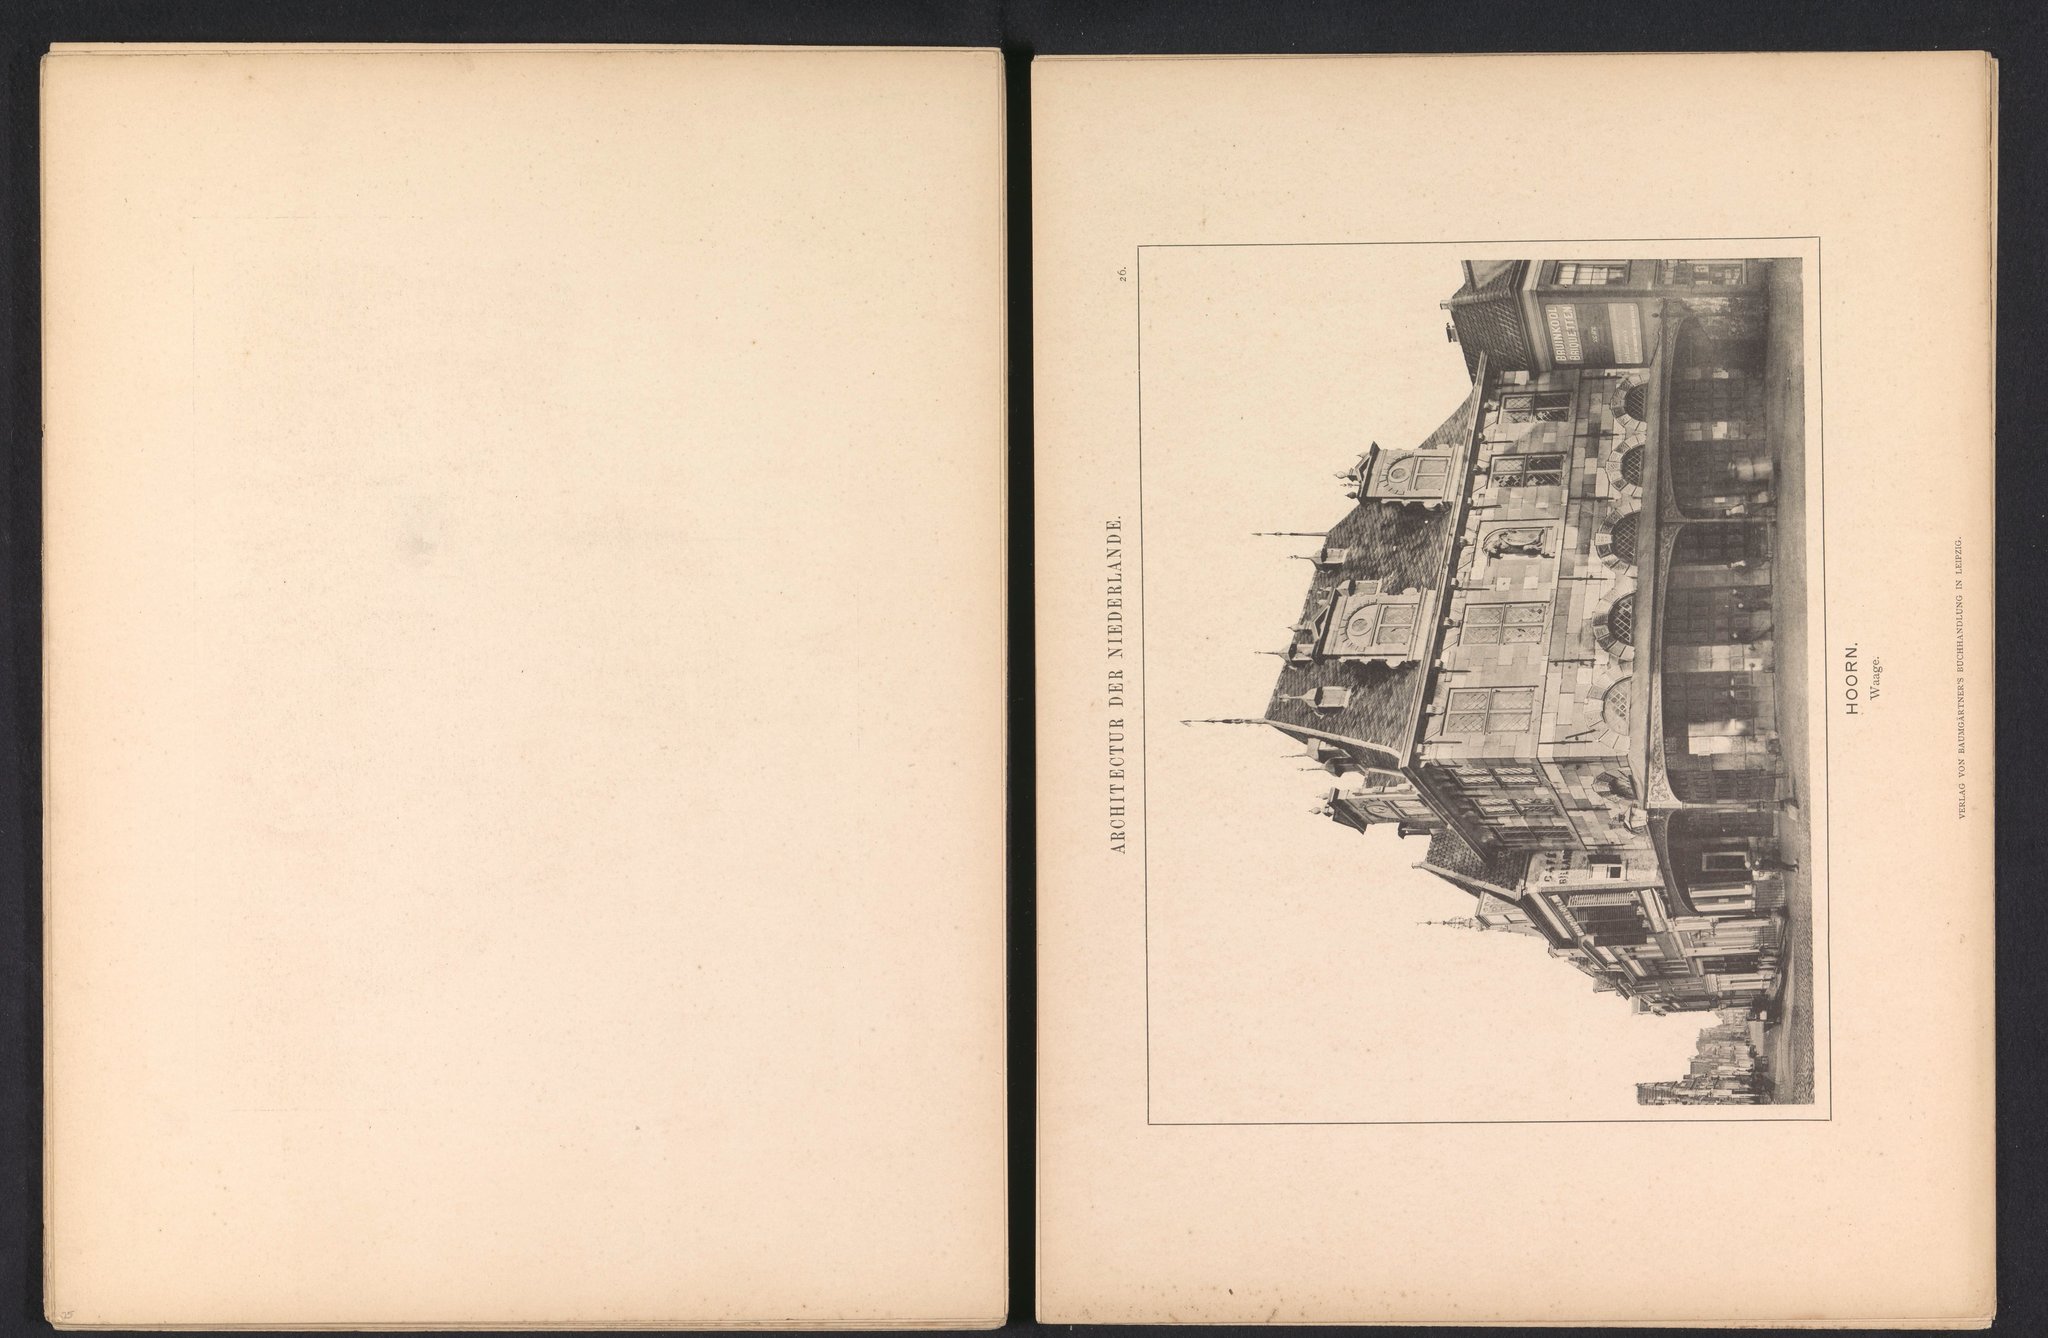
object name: page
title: Gezicht op de Waag in Hoorn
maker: Anonymous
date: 1884-1894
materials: paper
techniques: photograph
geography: hoorn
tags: façade (of house or building), weigh-house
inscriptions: number: ‘26.’